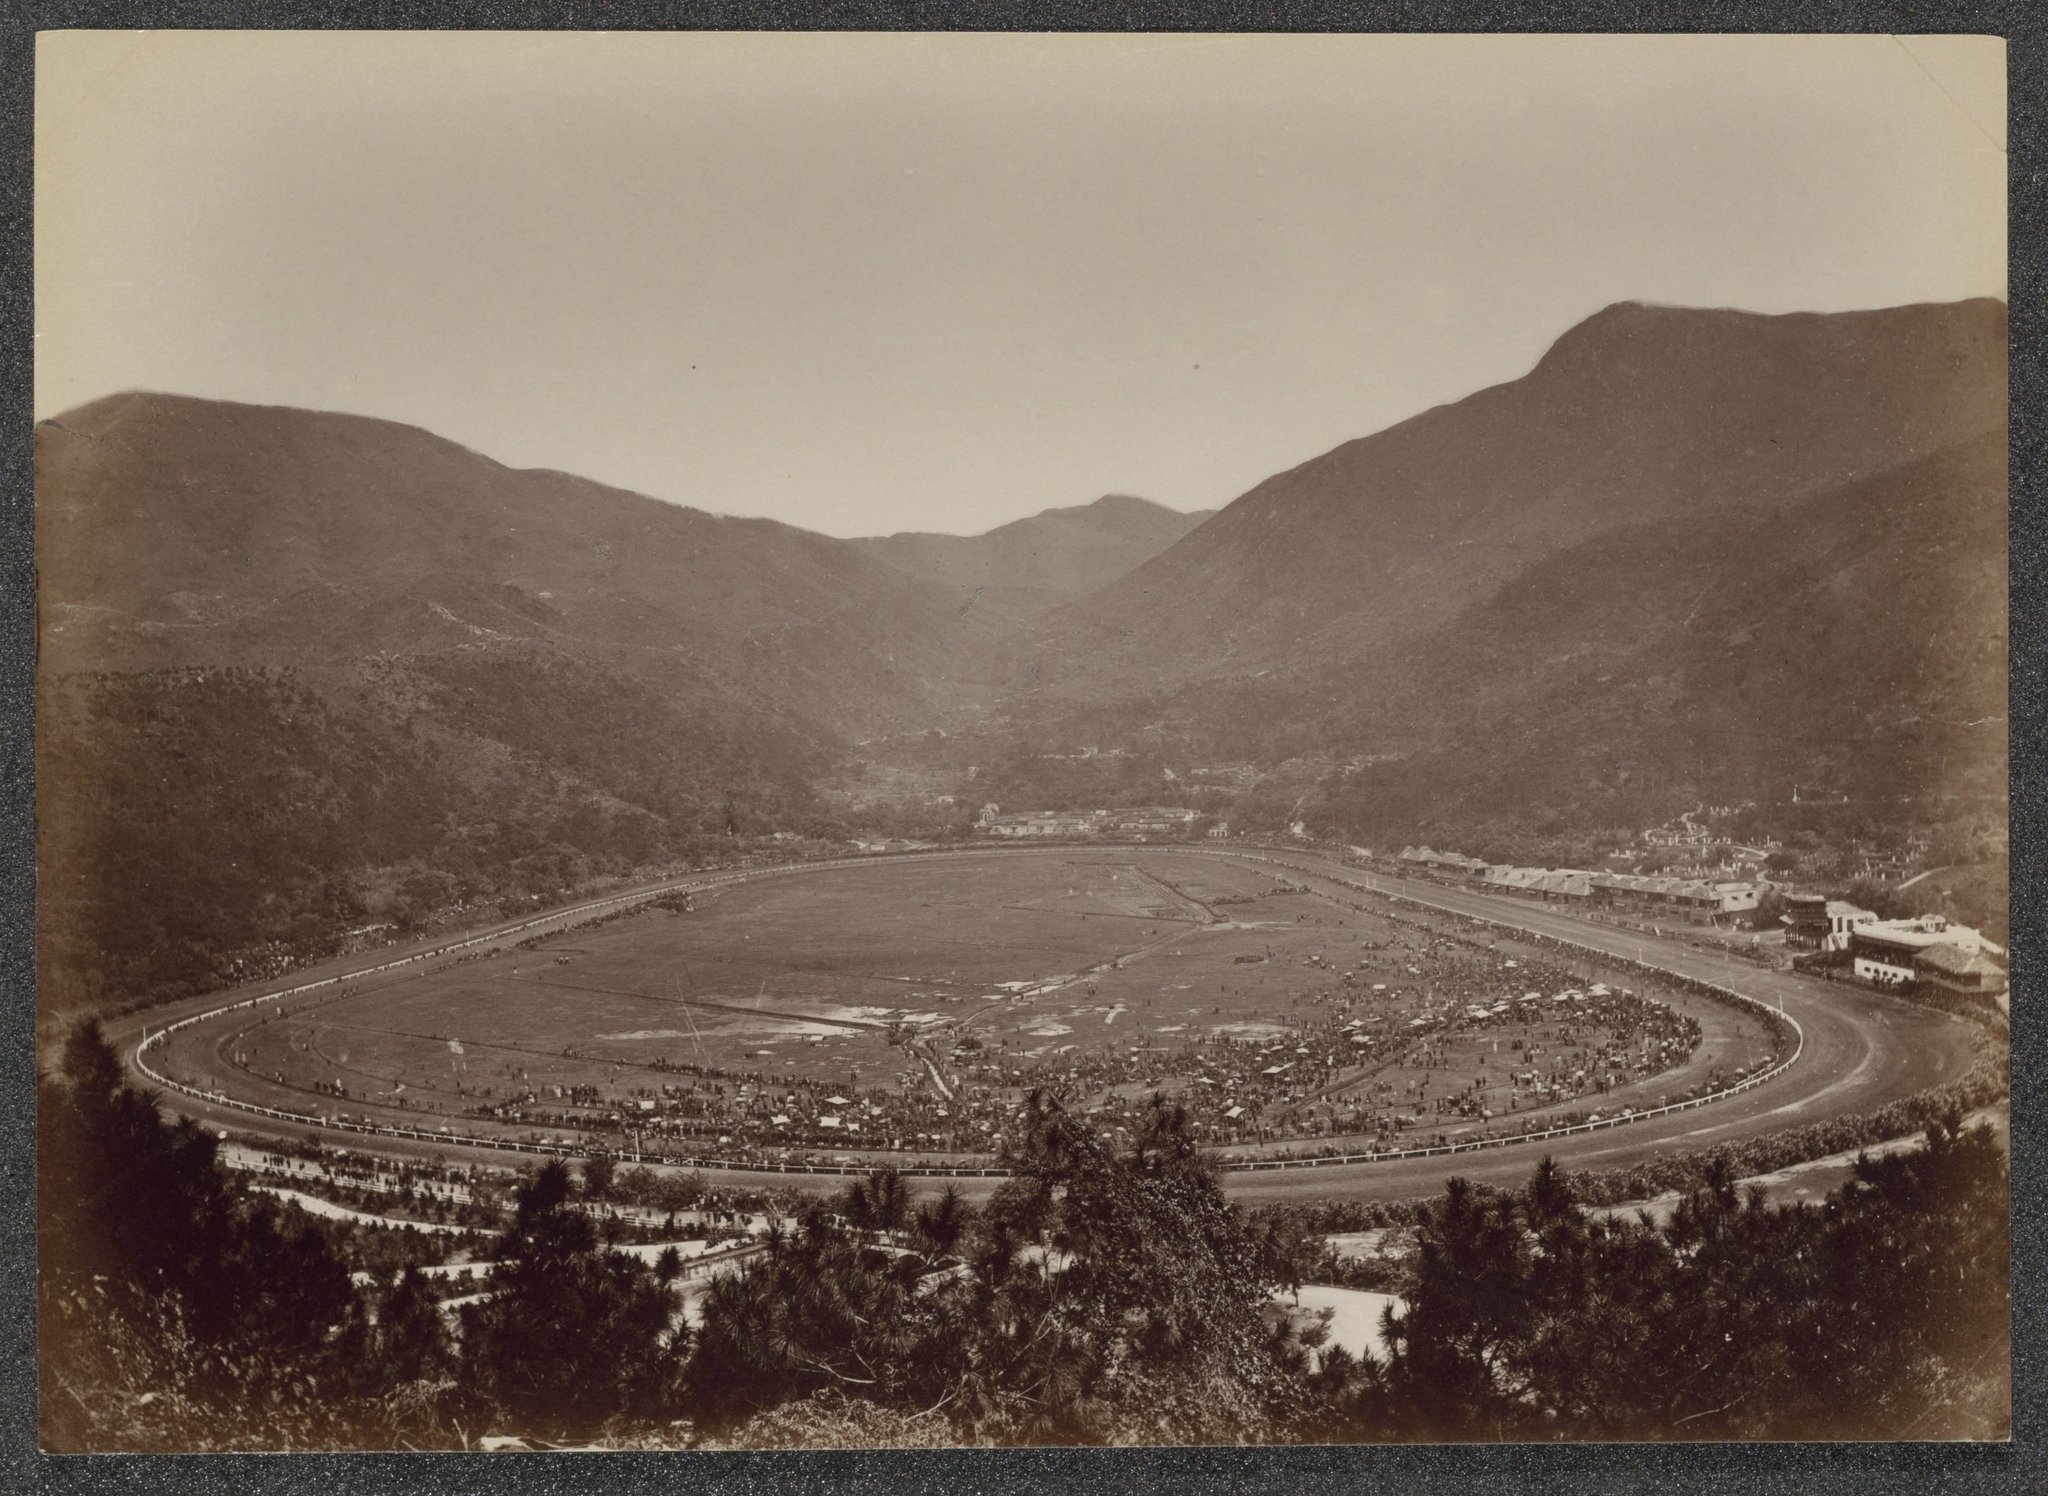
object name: photograph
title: Gezicht op Happy Valley, de paardenrenbaan van Hong Kong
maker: Anonymous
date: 1860-1900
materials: paper, photographic support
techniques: albumen print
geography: hong kong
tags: horse-racing, race-track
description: Onderdeel van Album met 50 foto's van een reis door Zuidoost-Azië.